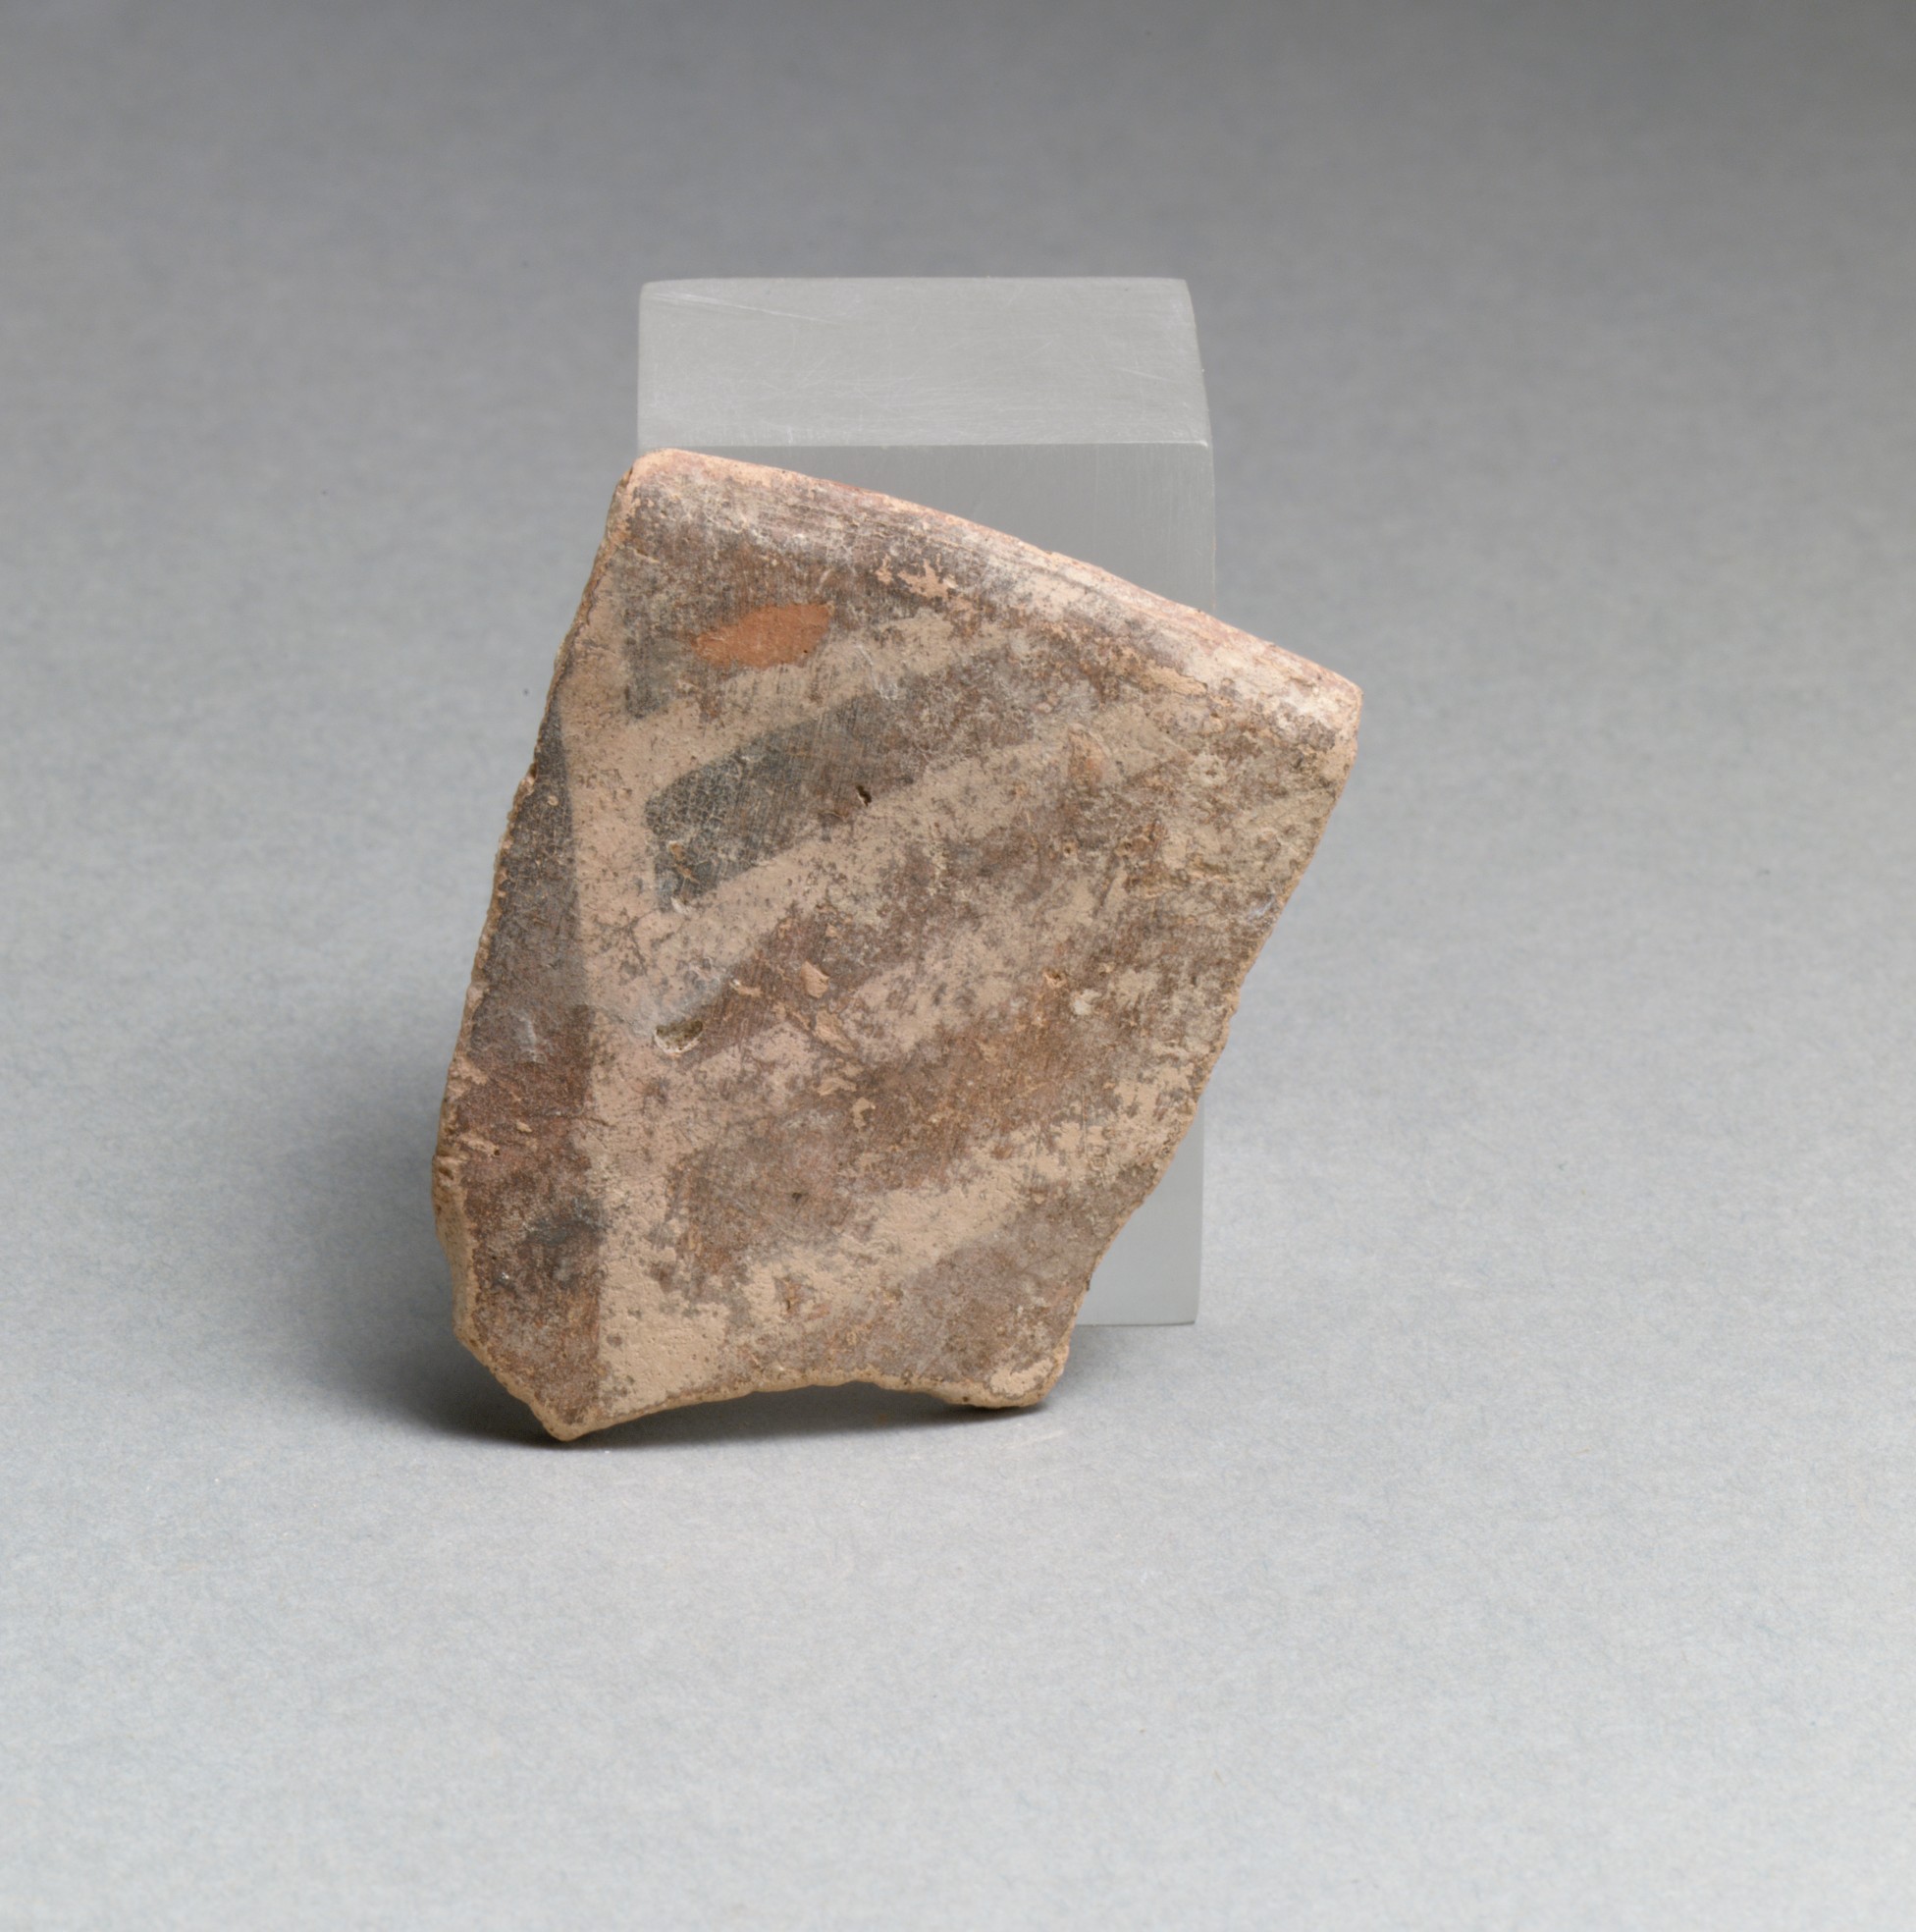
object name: vase fragment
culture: minoan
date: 2600-2000 BCE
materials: terracotta